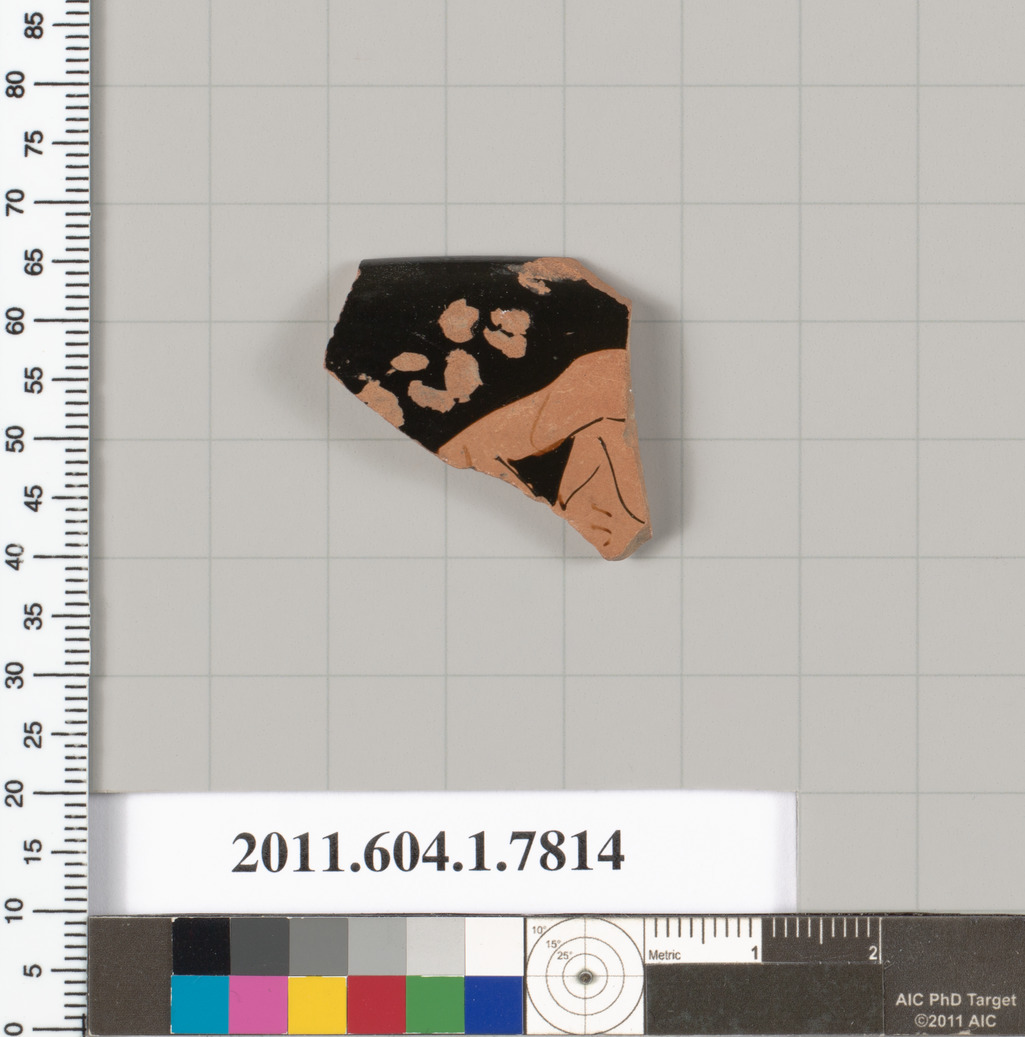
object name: kylix fragment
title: Terracotta rim fragment of a kylix (drinking cup)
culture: greek, attic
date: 460-450 BCE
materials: terracotta